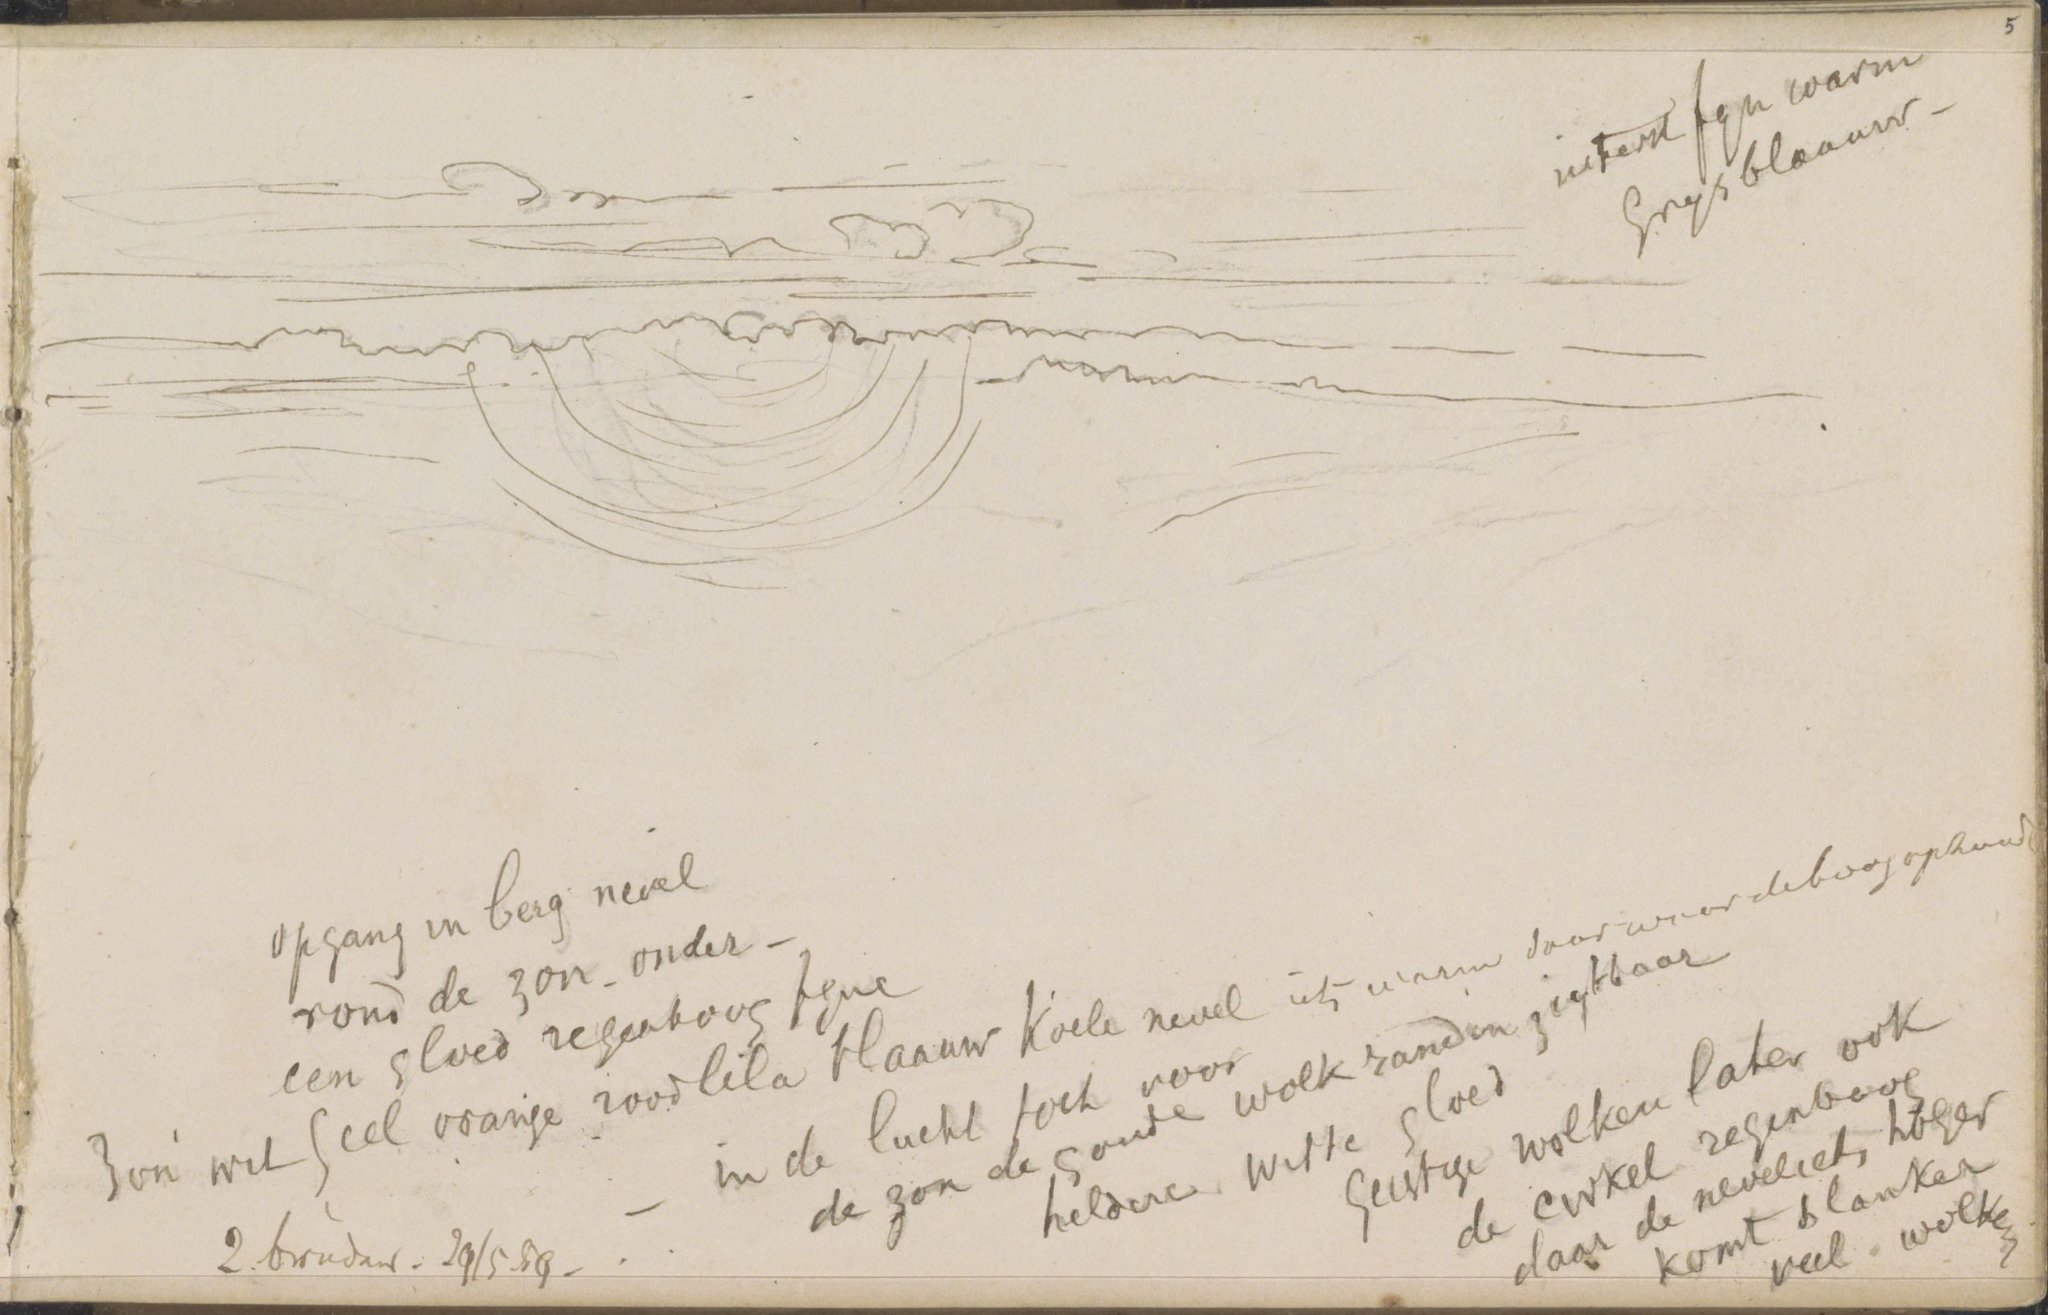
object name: sketchbook leaf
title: Zonsopgang met een regenboog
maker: johannes tavenraat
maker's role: draughtsman, painter, print maker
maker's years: 1809-1881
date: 1805-1859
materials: ink, paper, pencil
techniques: pen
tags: sun as celestial body, rainbow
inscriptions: date and inscription: ‘2 brüd[...] 29/5 59-’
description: Blad 5 recto uit een schetsboek met 48 bladen.